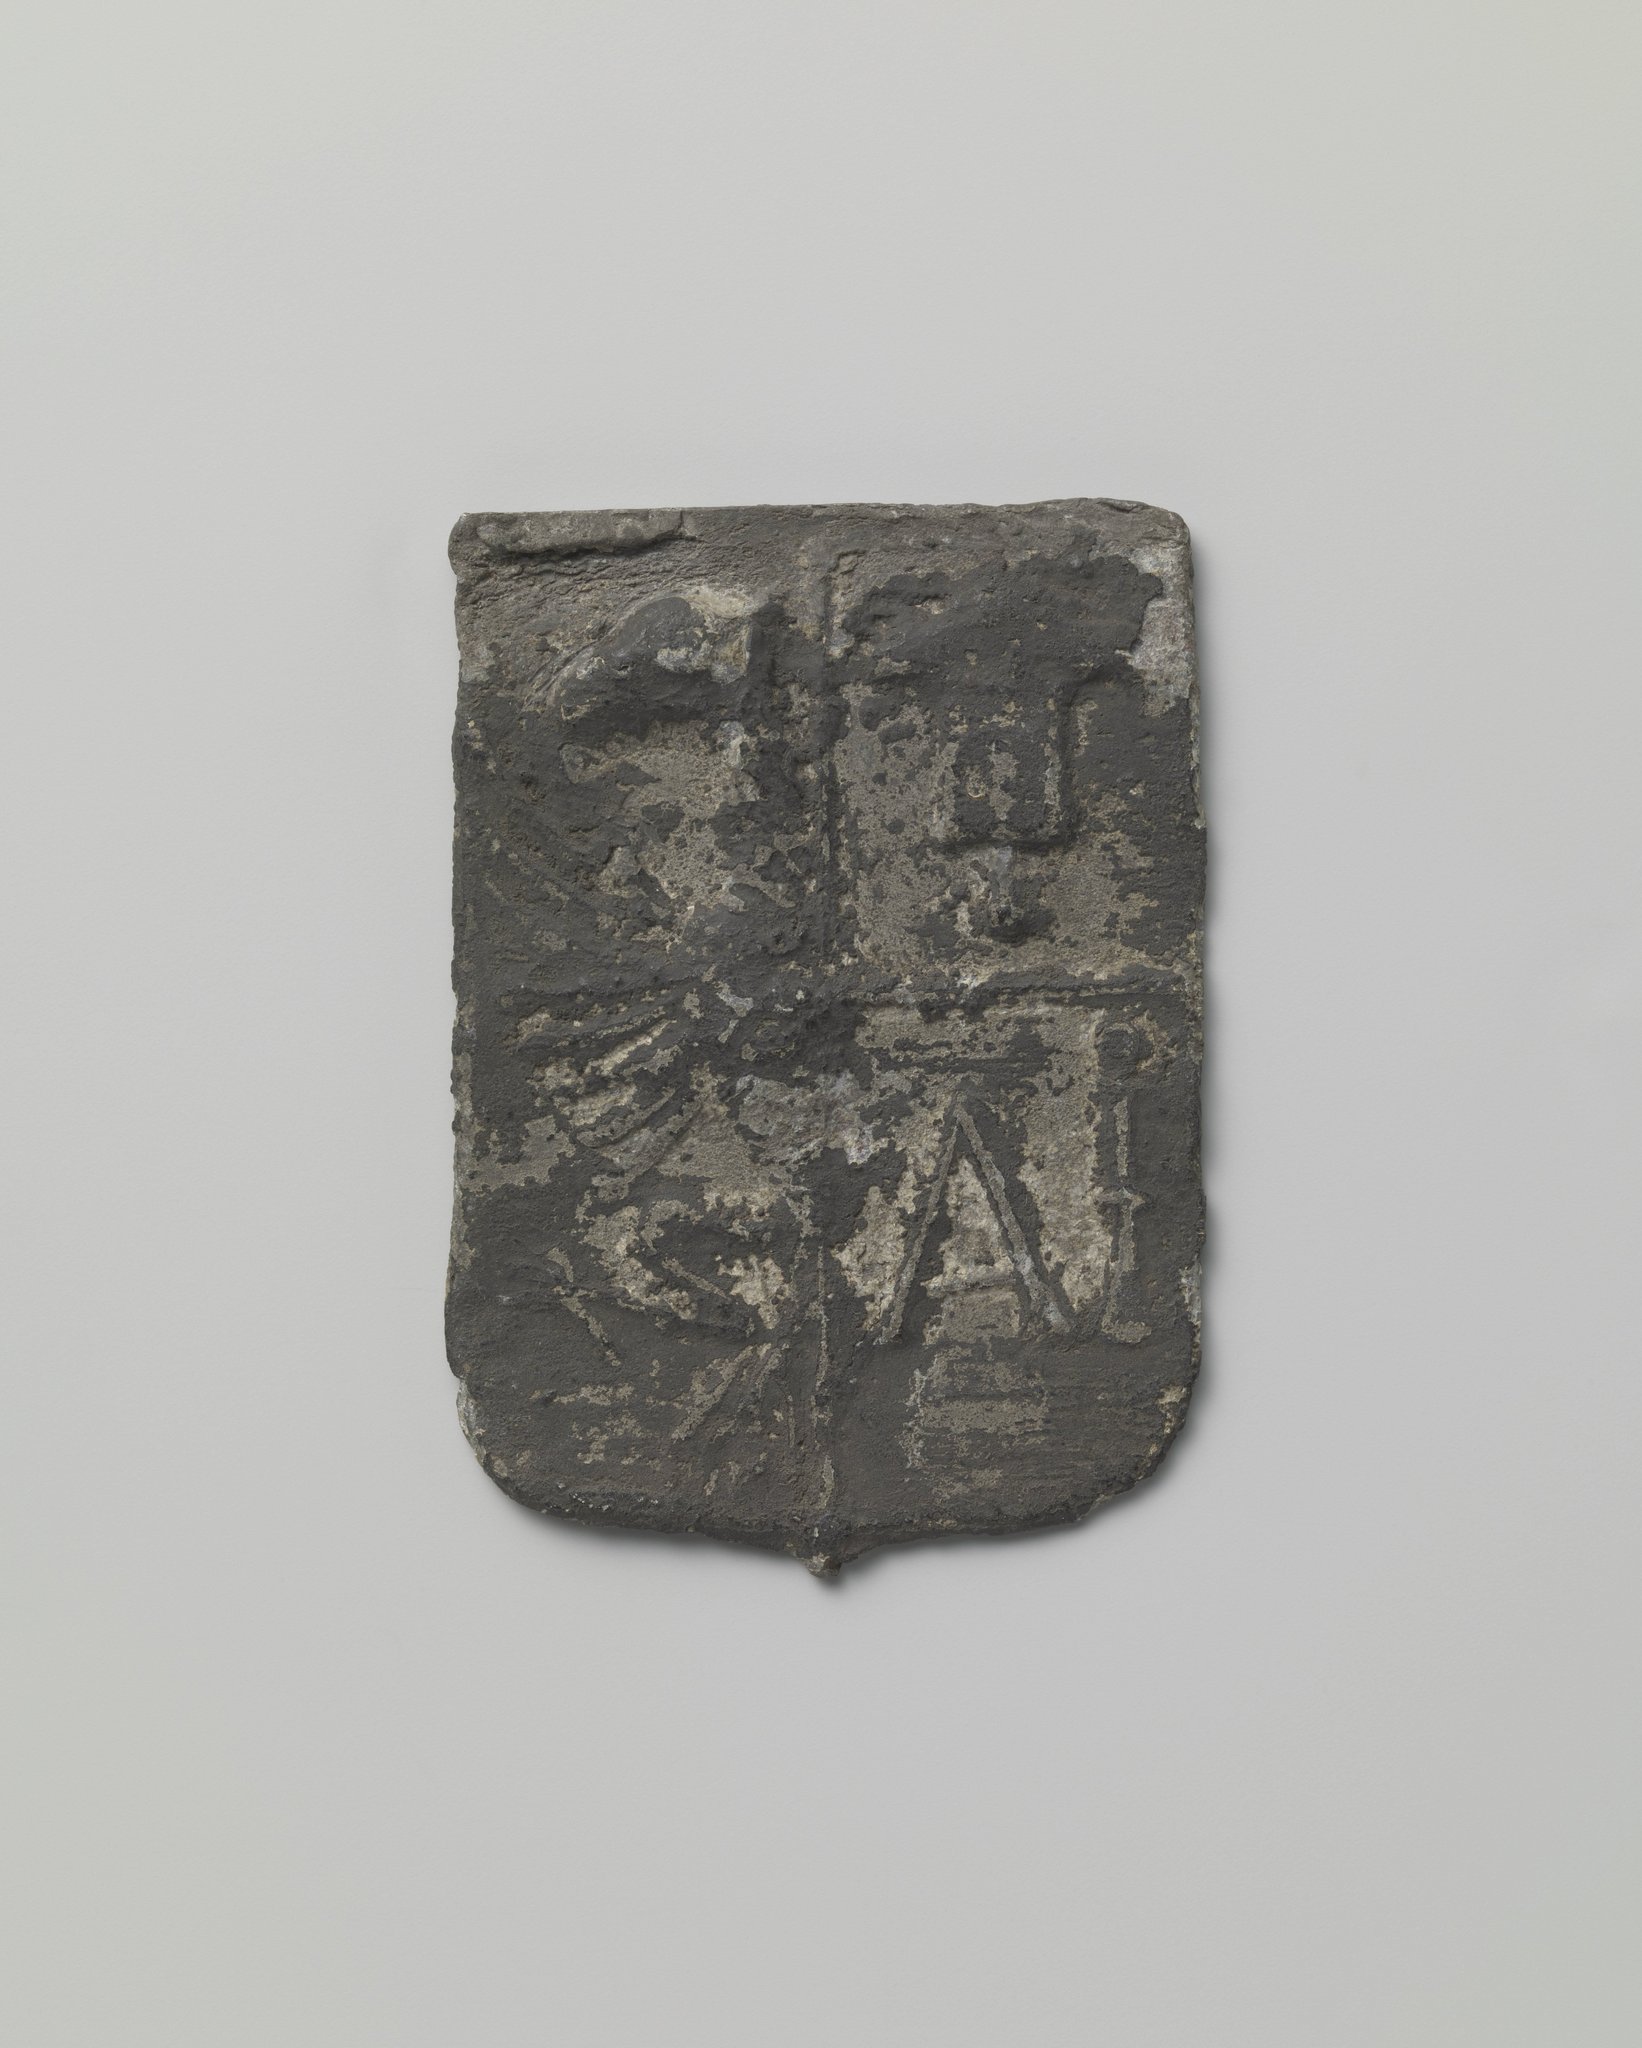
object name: switch plate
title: Dekplaat van lood, schildvormig voor het het bedekken van de nagels van een loden dakbekleding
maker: Anonymous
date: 1400-1950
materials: lead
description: Dekplaat van lood, schildvormig voor het het bedekken van de nagels van een loden dakbekleding. Daarop in laag reliëf gedeeld, rechts een halve adelaar, links een peillood en de letters A.I. Afkomstig van de torenspits van Hindelopen.